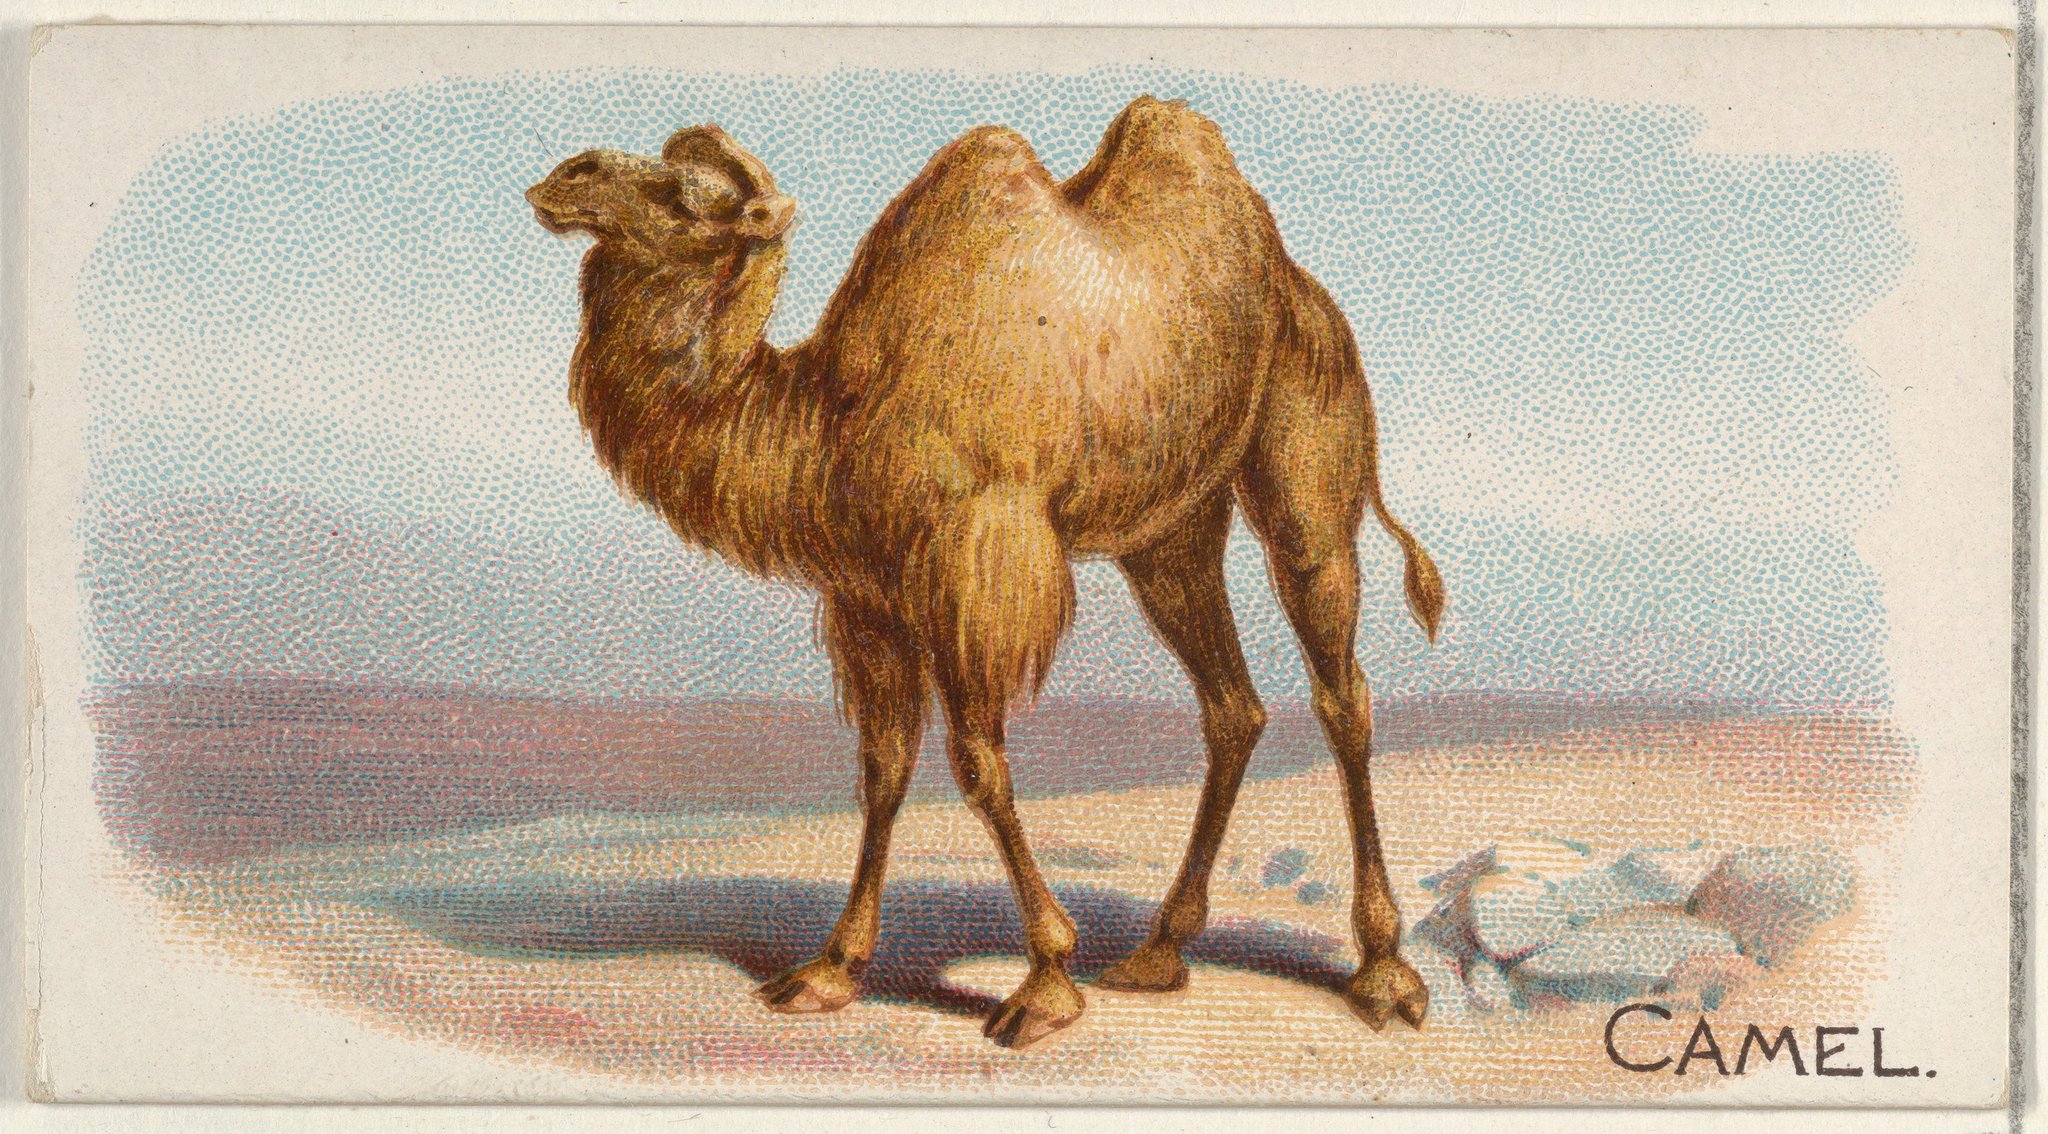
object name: print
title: Camel, from the Quadrupeds series (N21) for Allen & Ginter Cigarettes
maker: allen & ginter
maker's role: publisher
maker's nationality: american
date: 1890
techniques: color lithograph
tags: camels